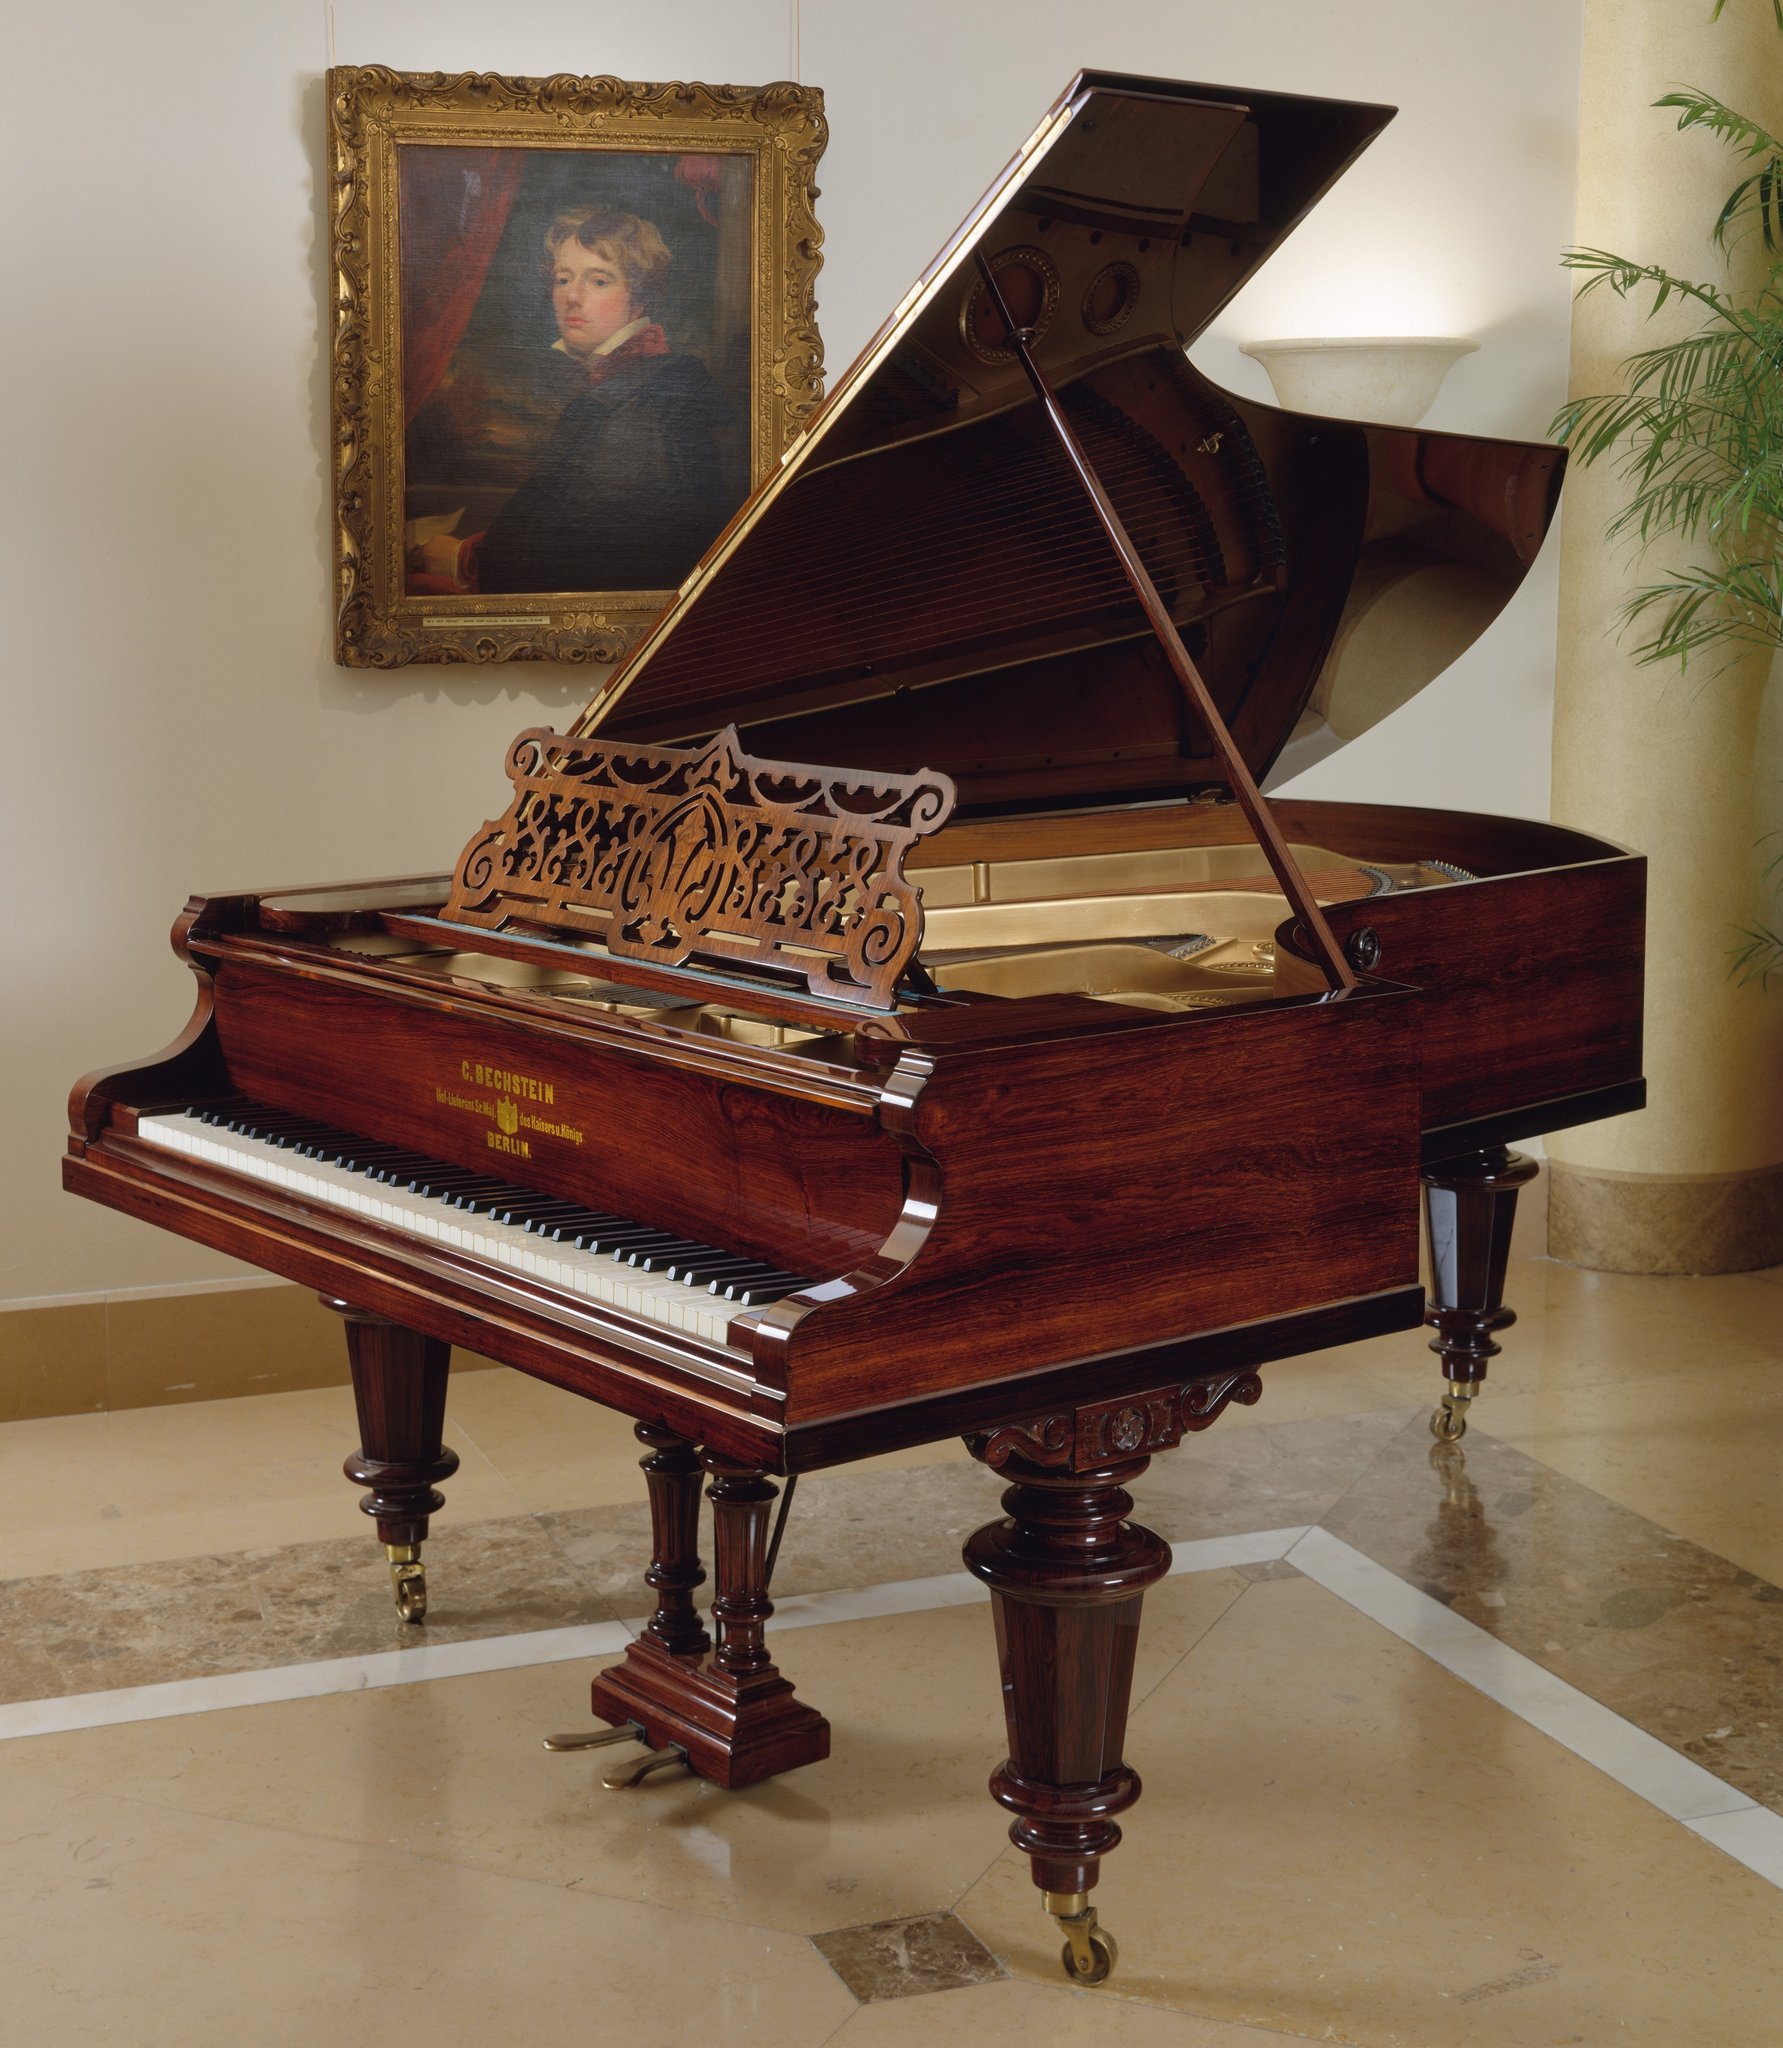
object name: grand piano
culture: german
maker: carl bechstein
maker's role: maker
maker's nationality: german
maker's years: 1826-1900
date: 1893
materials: metal, wood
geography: germany